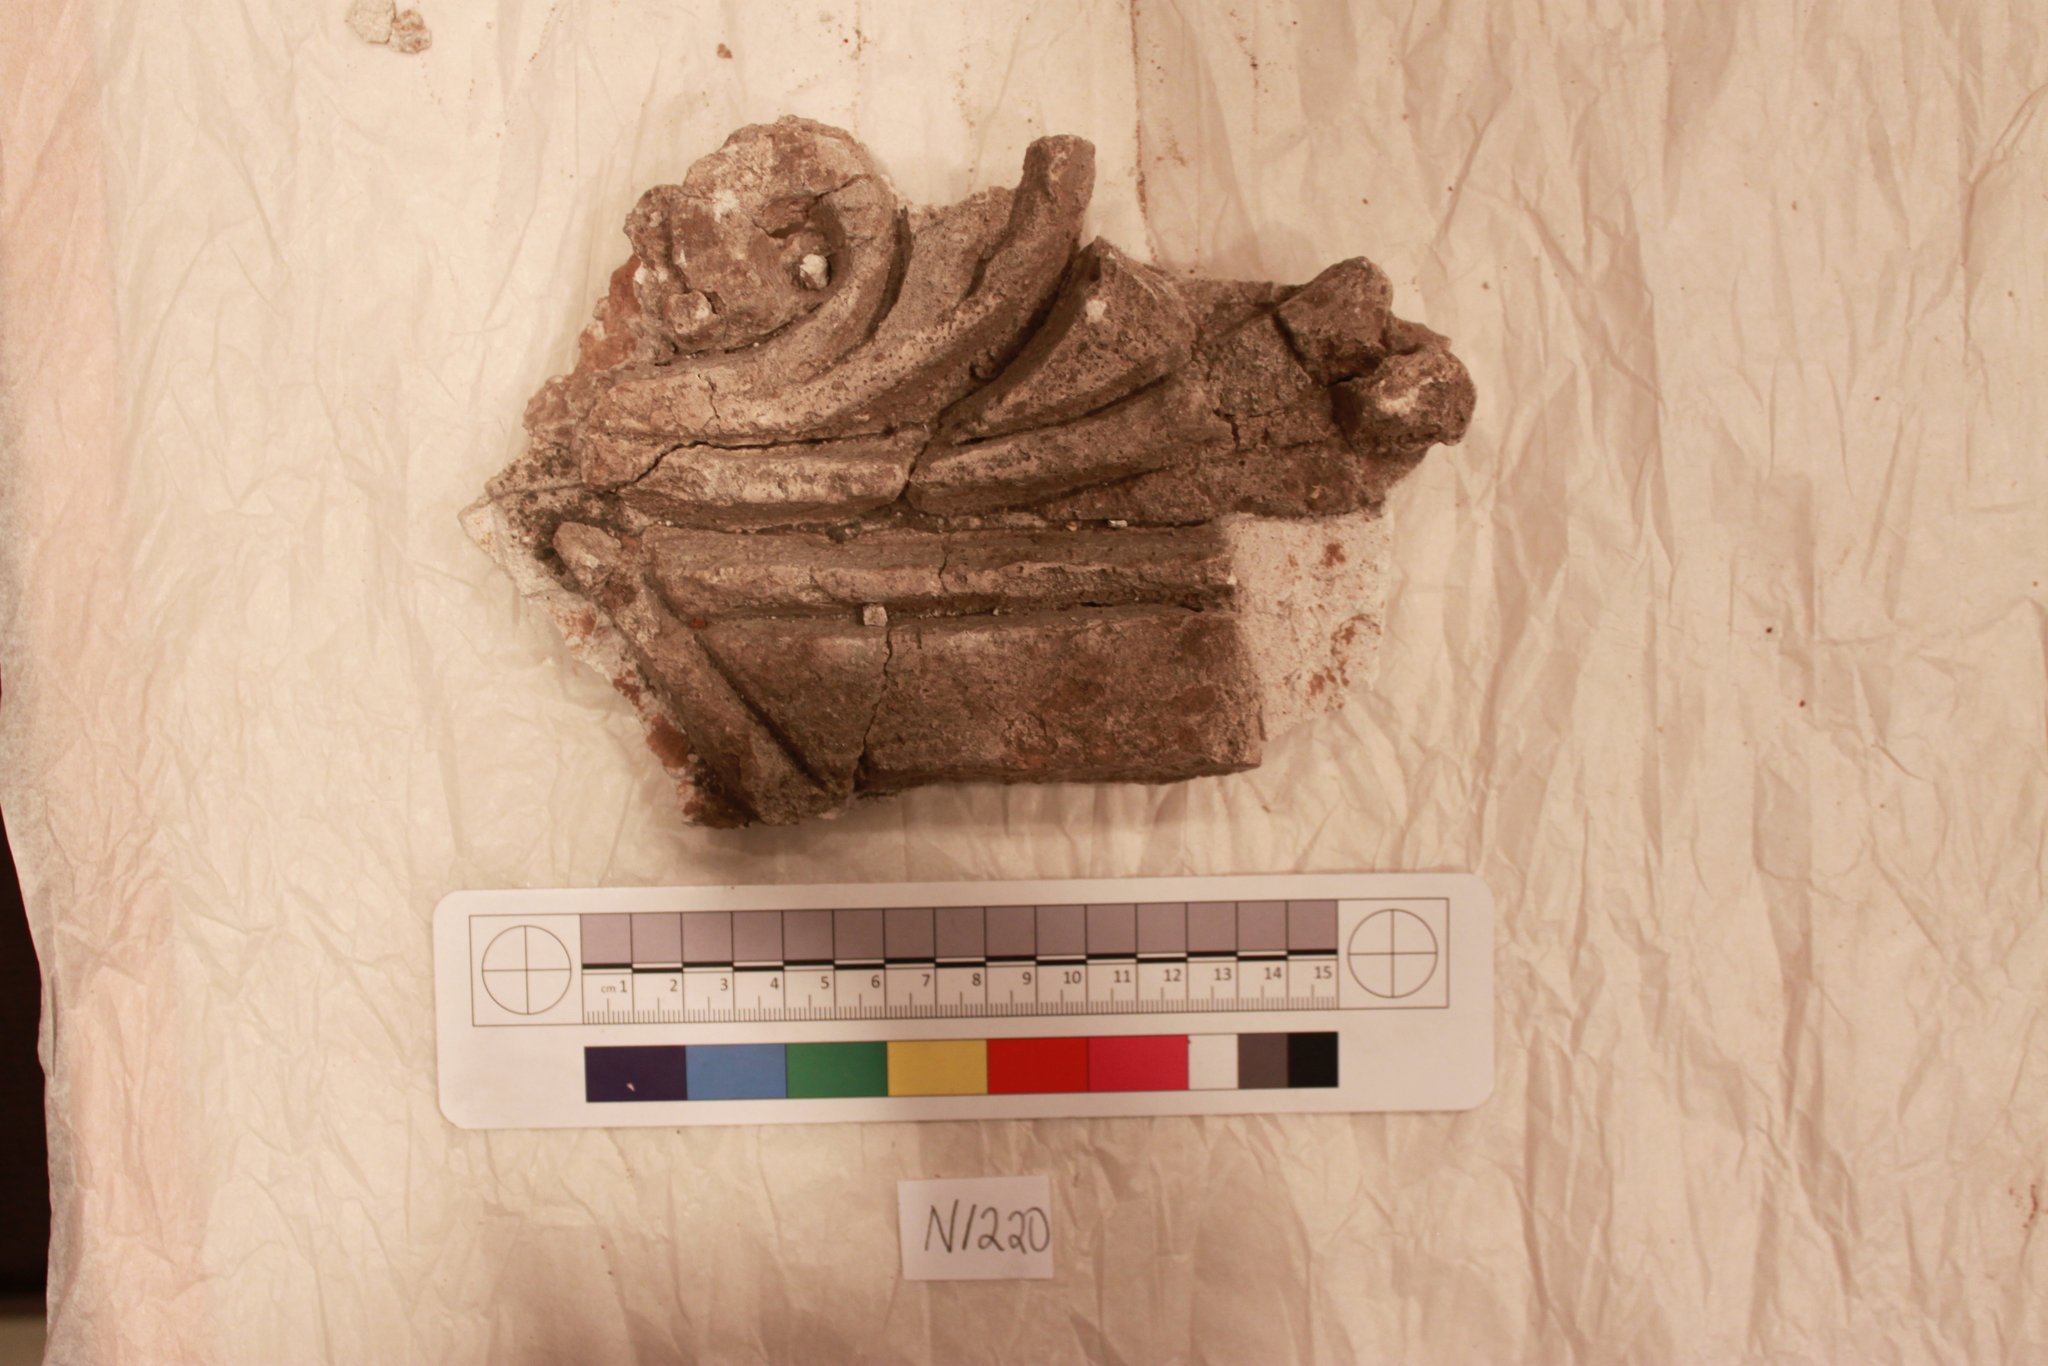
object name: fragment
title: Stucco Fragment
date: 701-1200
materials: plaster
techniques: carving, painting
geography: iran